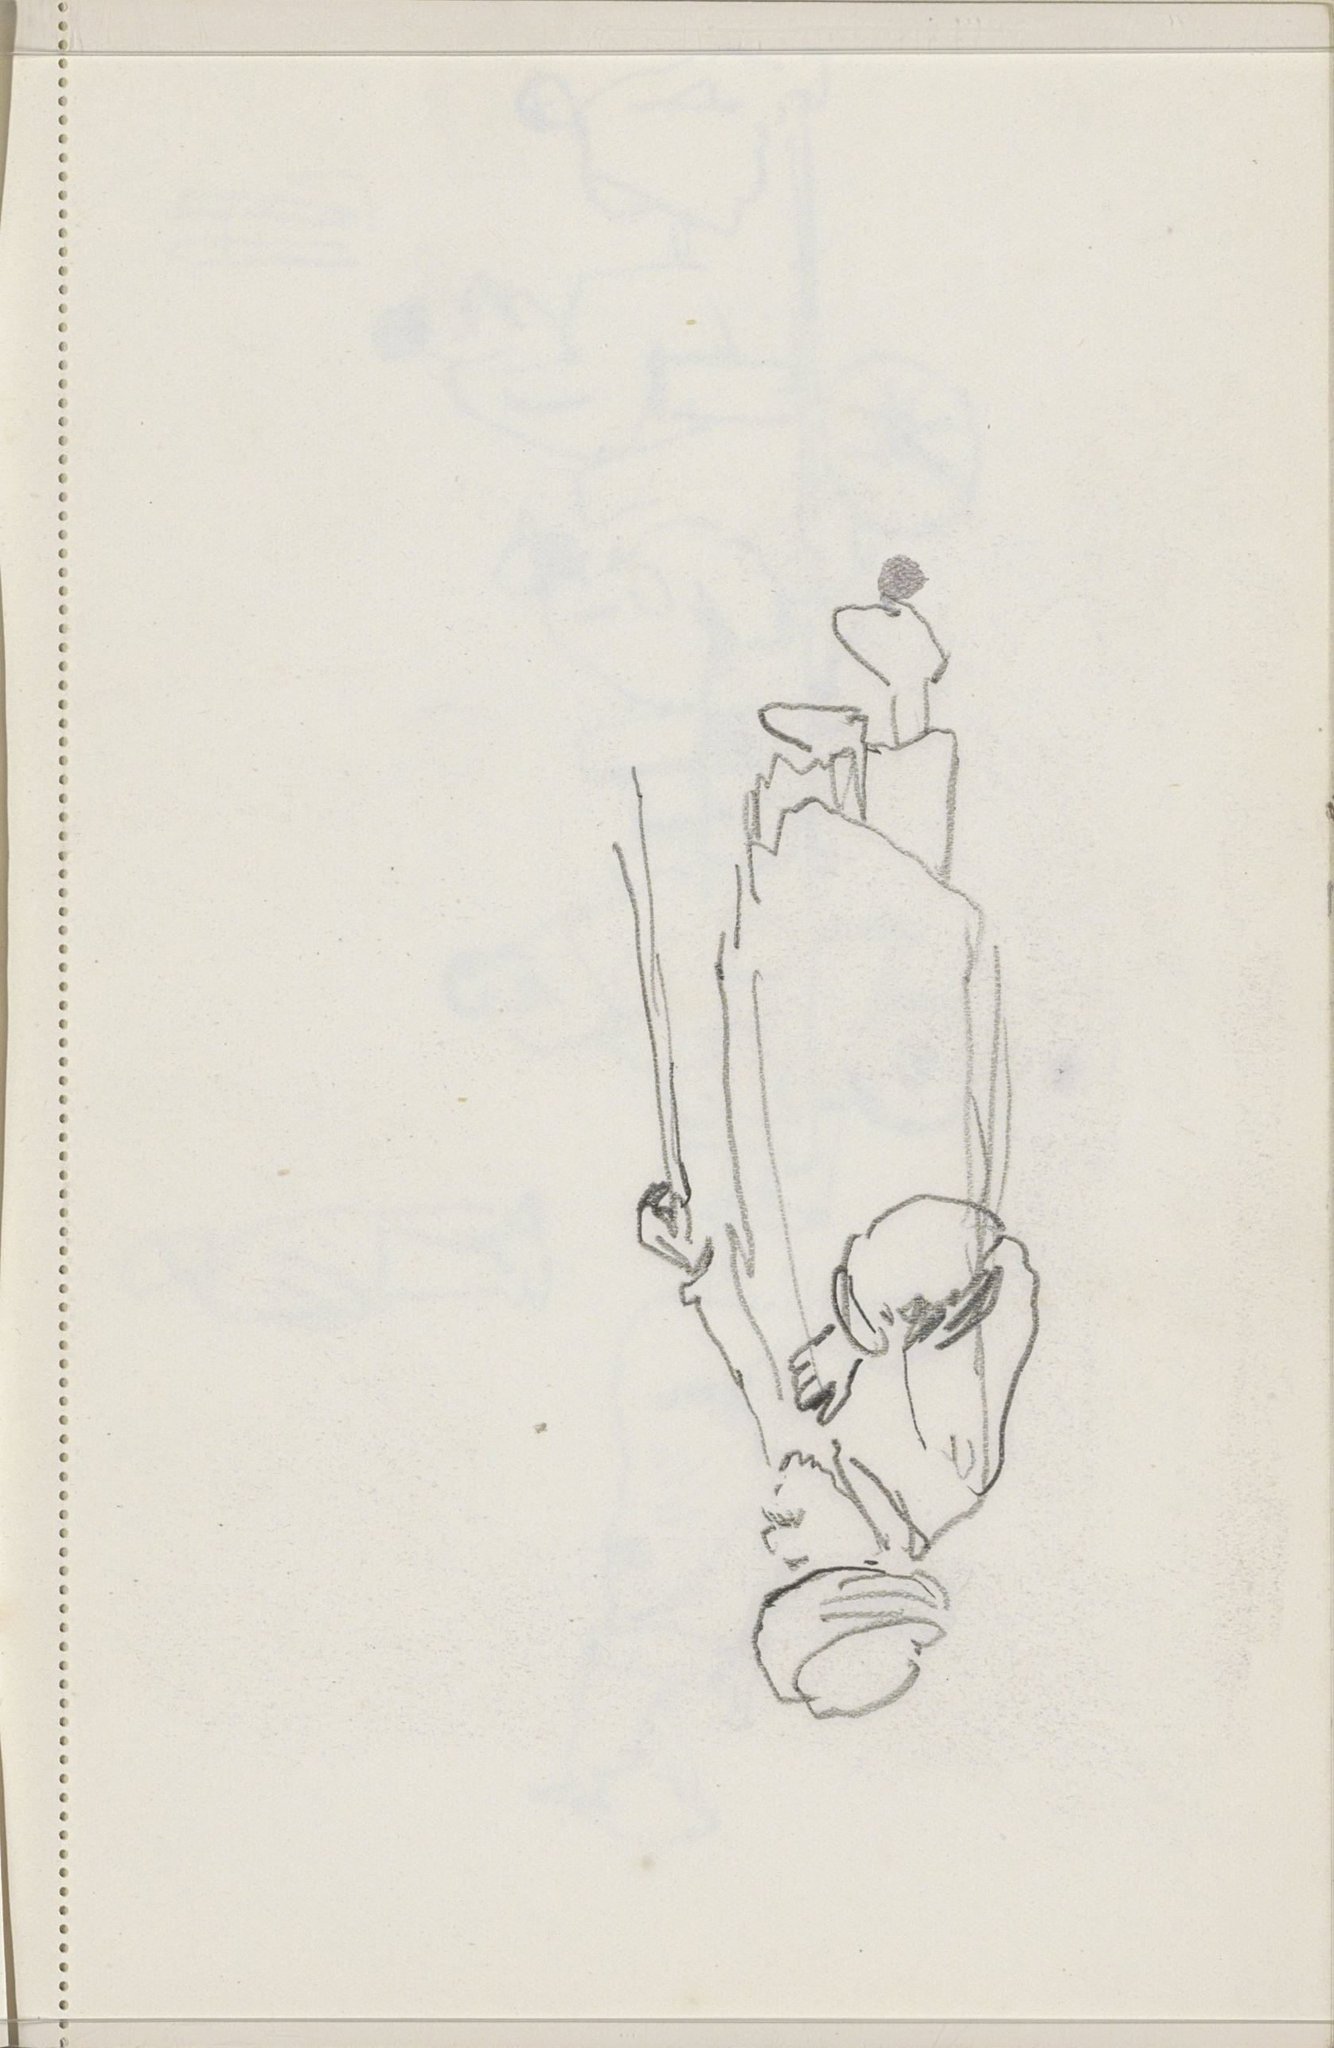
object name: sketchbook leaf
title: Oosterse man met een wandelstok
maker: cornelis vreedenburgh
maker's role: draughtsman, print maker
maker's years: 1880-1946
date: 1936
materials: paper, pencil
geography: maghreb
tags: standing figure, walking-stick, staff, folk costume, regional costume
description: De man draagt een tulband op het hoofd. Blad 25 recto uit een schetsboek met 73 bladen.